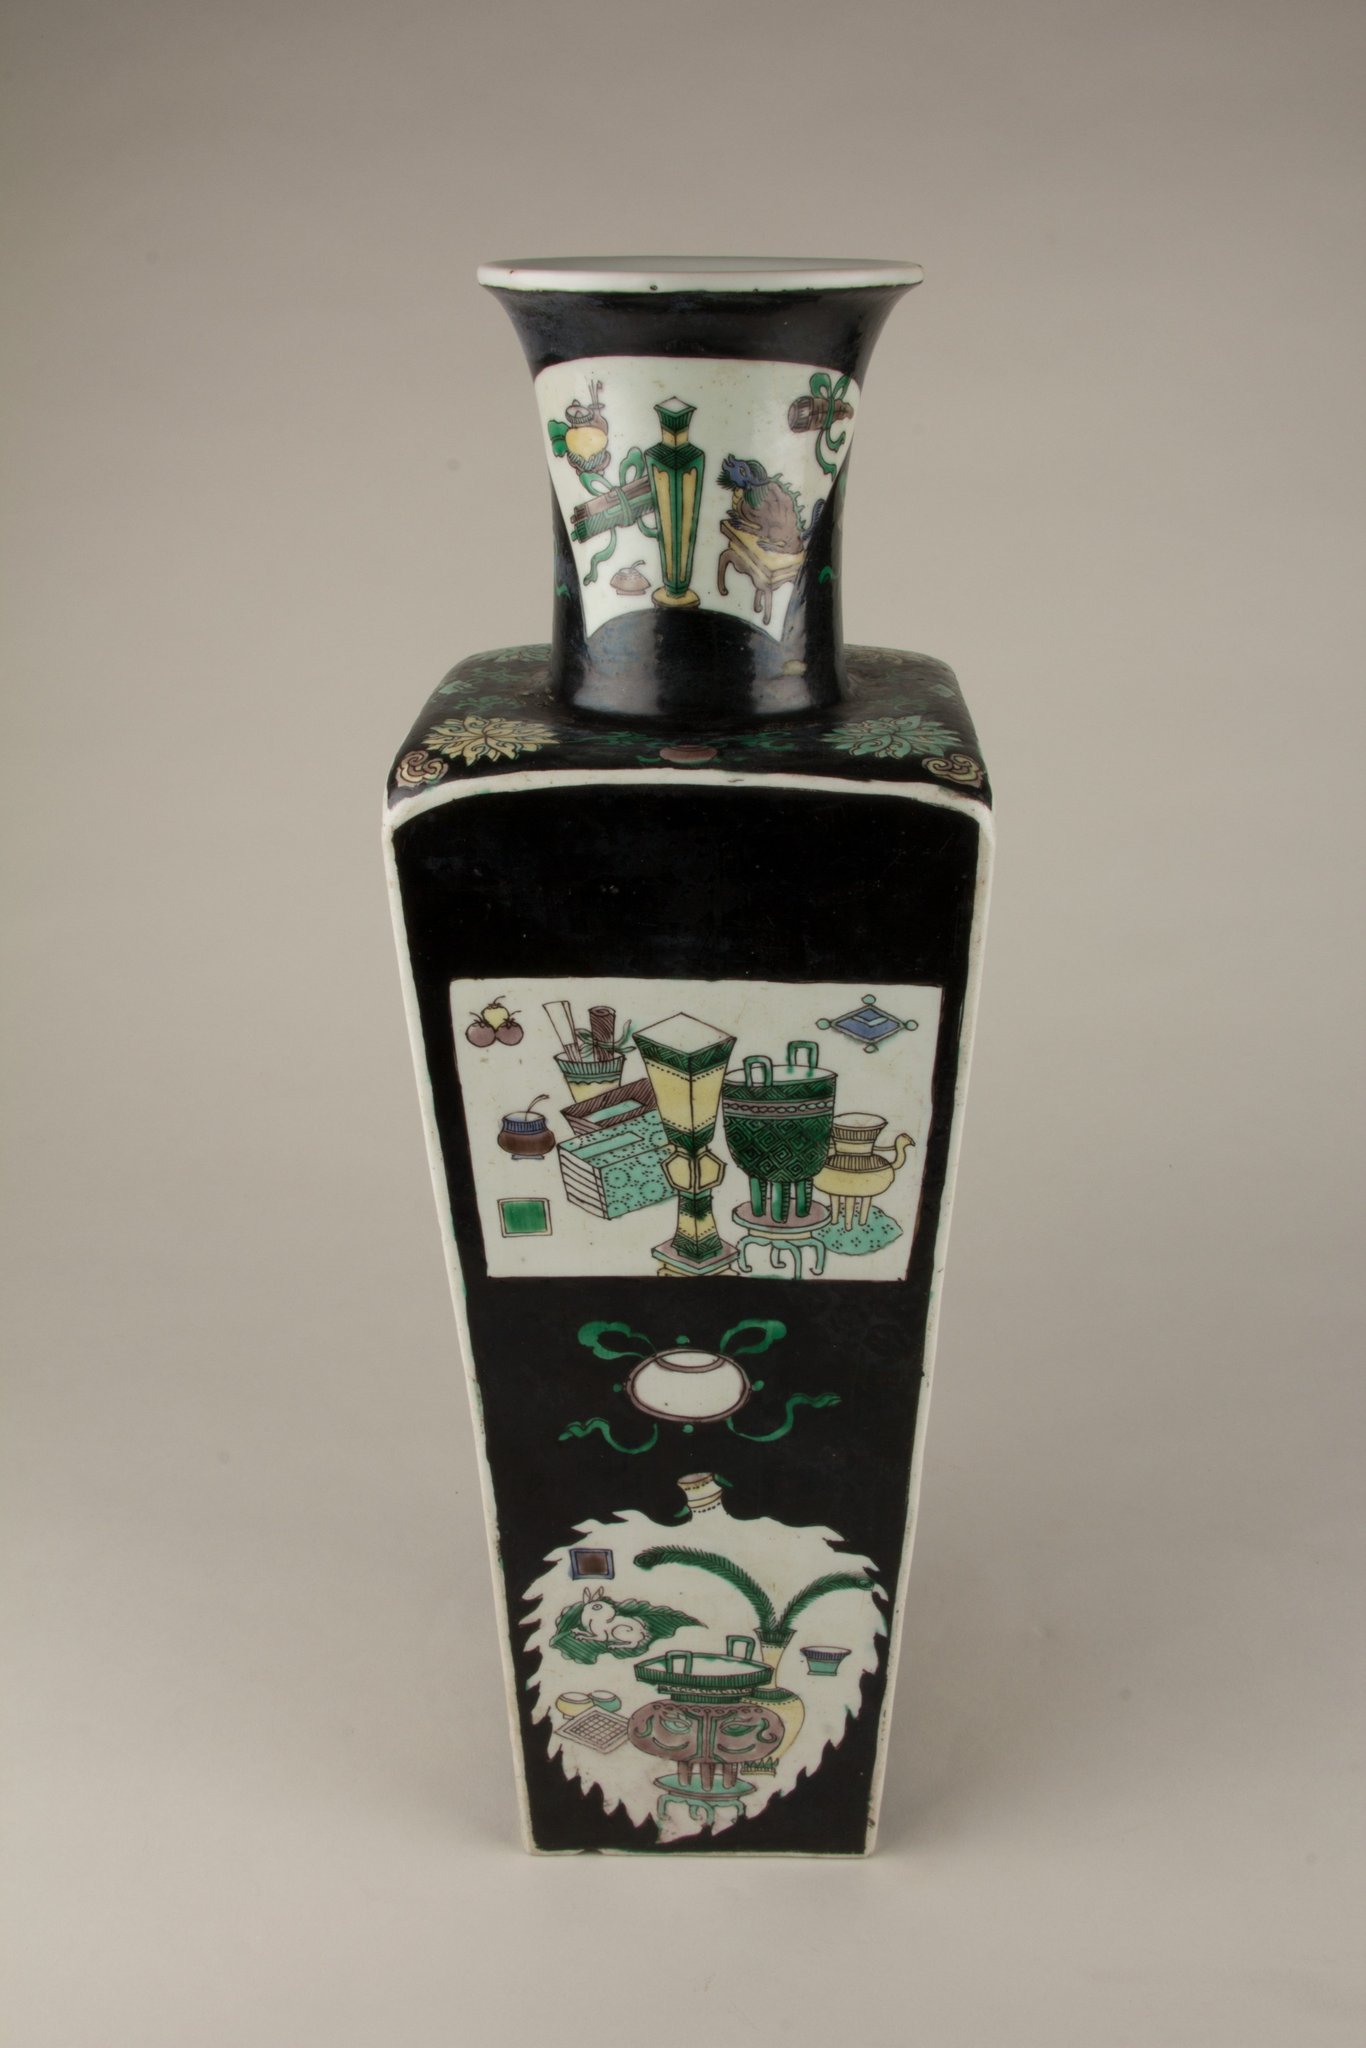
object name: vase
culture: chinese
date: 1662-1722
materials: enamel, porcelain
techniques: painting